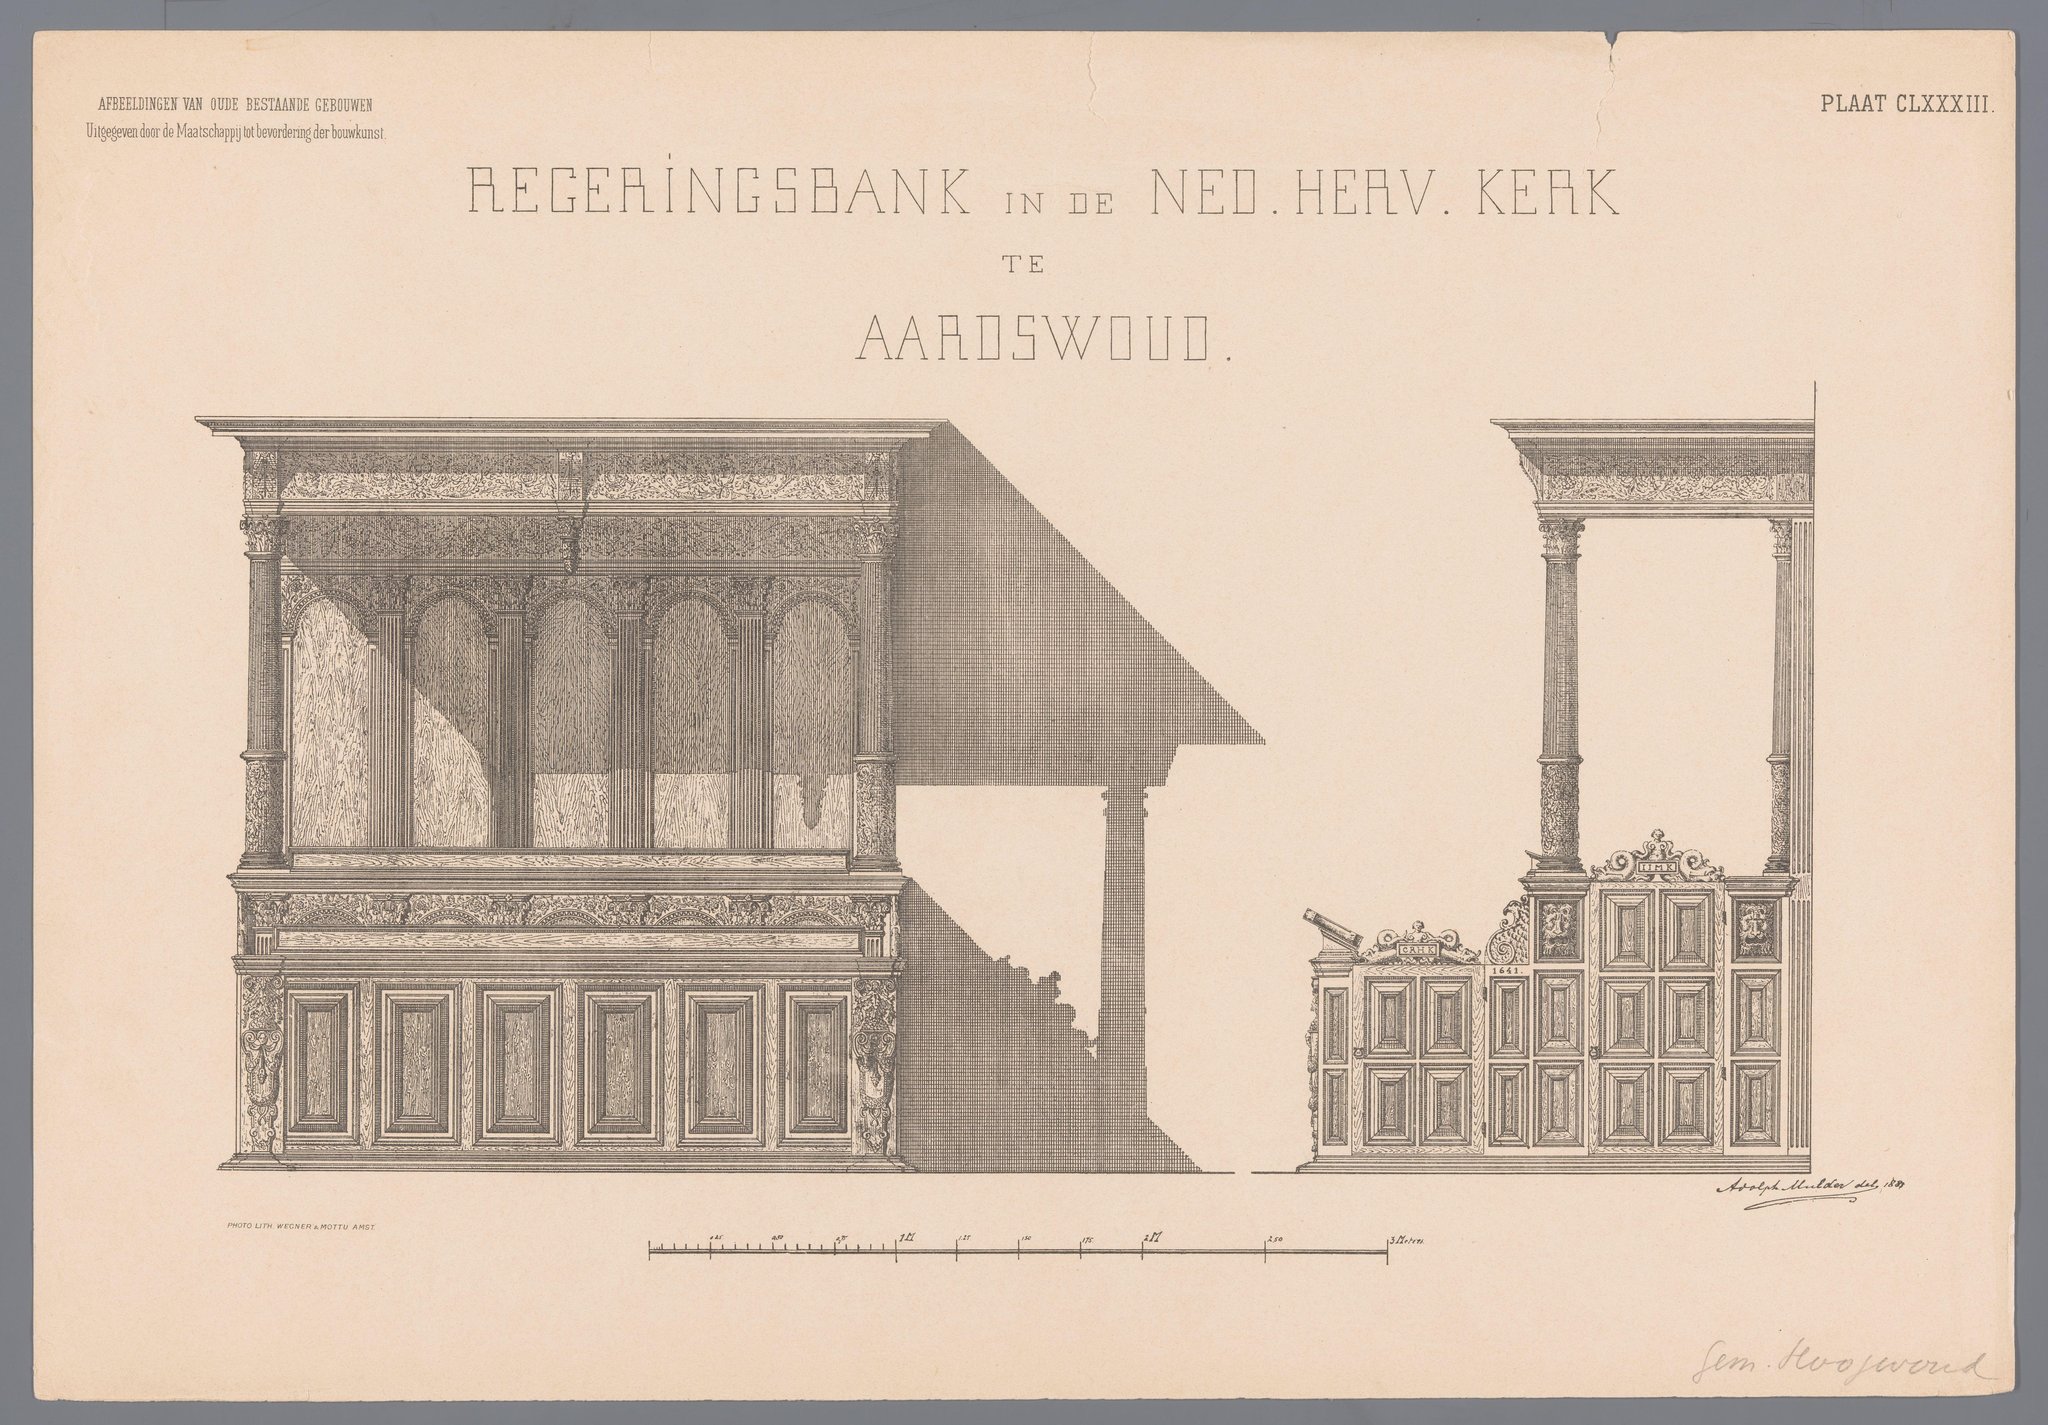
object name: photomechanical print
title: Regeringsbank in de Ned. Herv. Kerk. te Aardswoud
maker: a.j.m. mulder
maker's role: engineer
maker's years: 1856-1936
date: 1883-1917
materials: paper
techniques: photolithography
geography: amsterdam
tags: interior of church